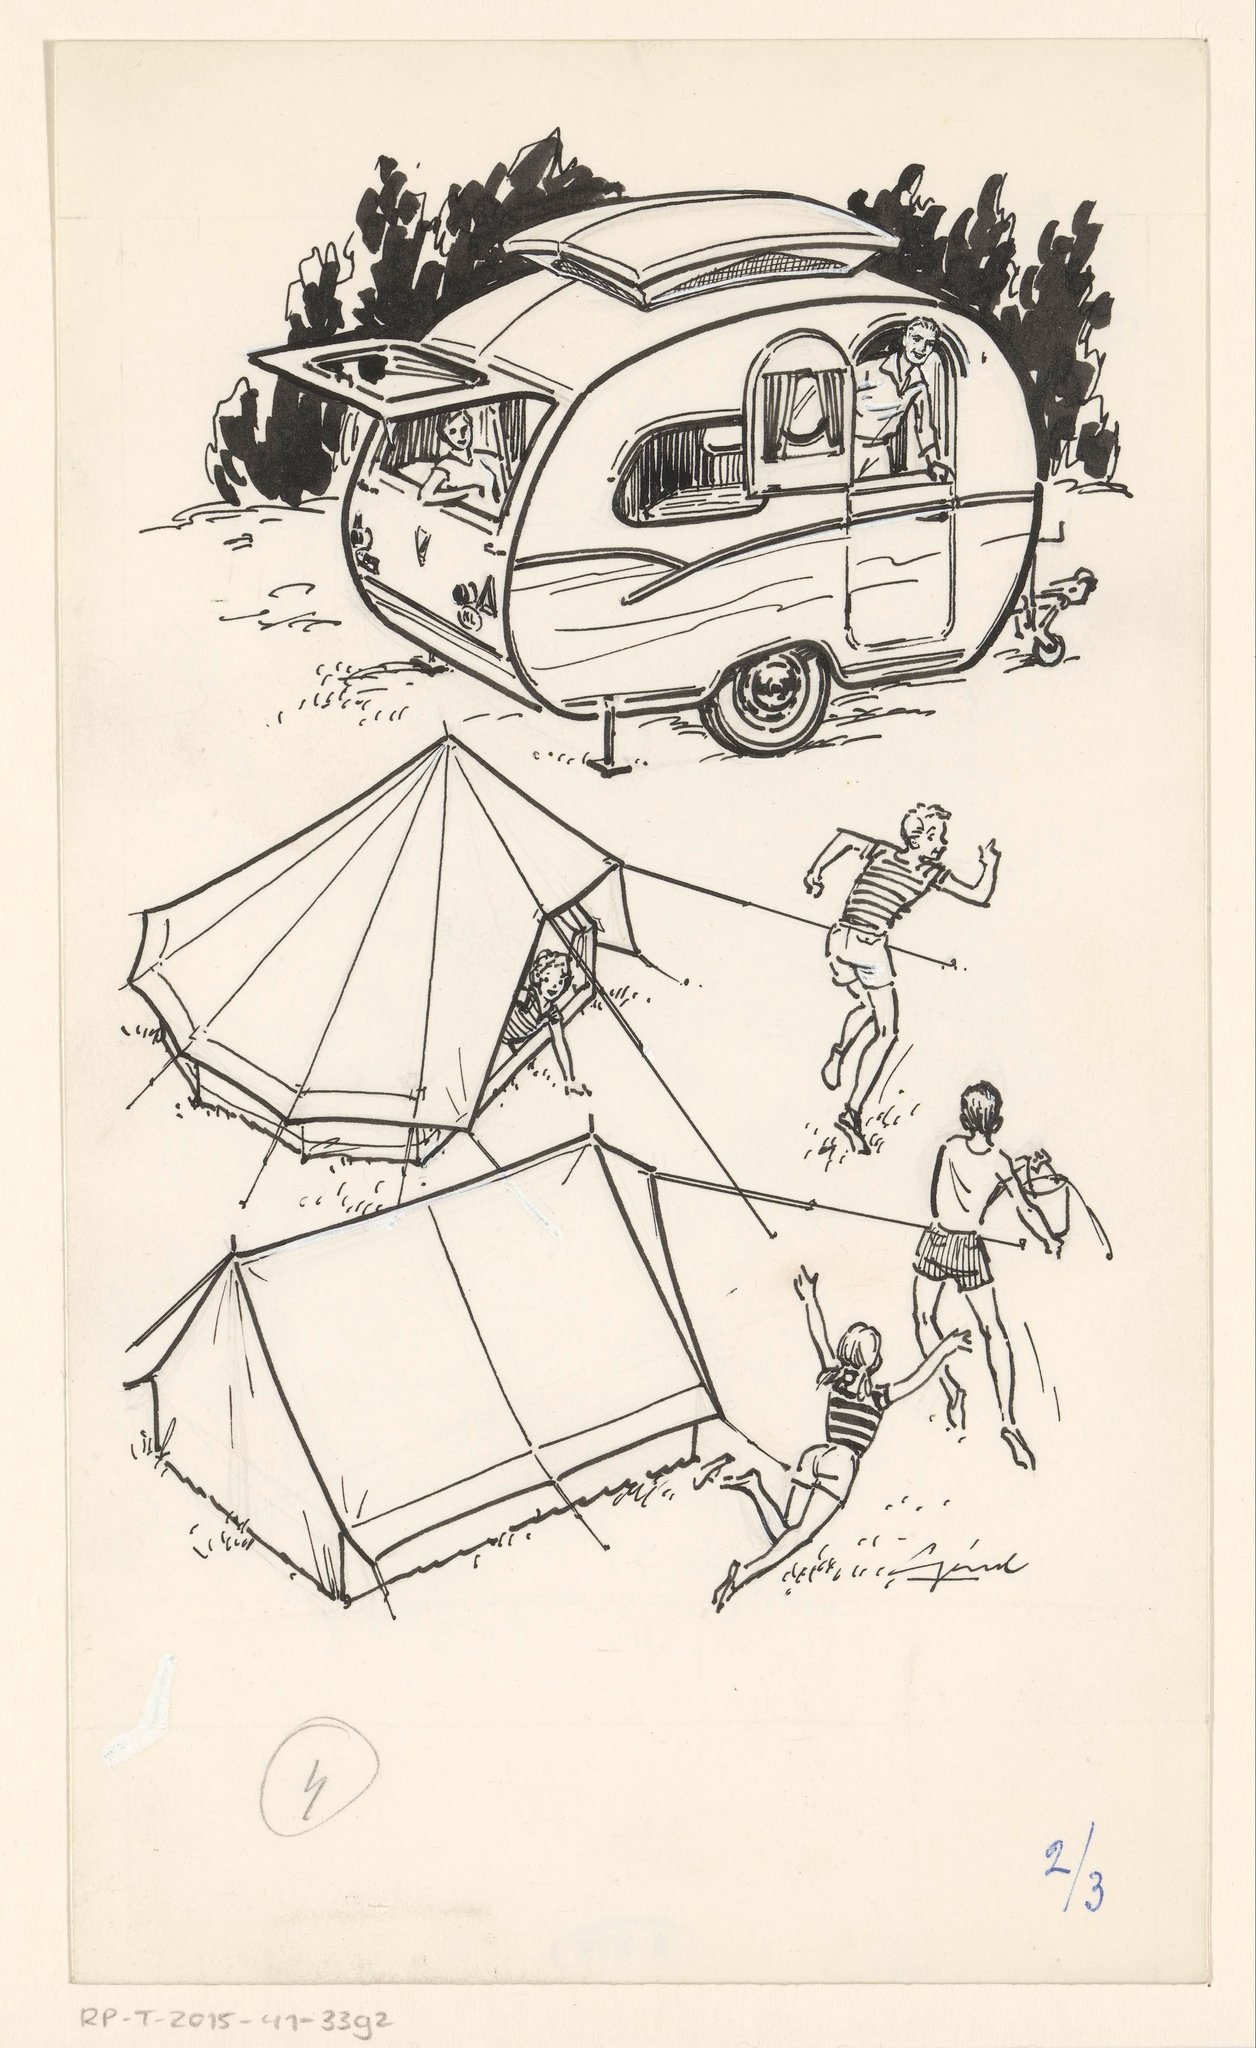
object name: boekillustratie ontwerp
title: Spelende kinderen op een camping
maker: Anonymous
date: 1930-1970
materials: paint, ink, paper, pencil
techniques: brush, pen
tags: children's games and plays, tent, caravan (trailer)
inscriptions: signature: ‘Gérard[?]’, number: ‘4’, collector's mark: Lugt 2228a, :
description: Een man en vrouw in een caravan kijken naar een groep spelende kinderen. De kinderen rennen voor twee tenten langs. Eén jongen probeert een emmer water over een jongen voor hem te gooien.